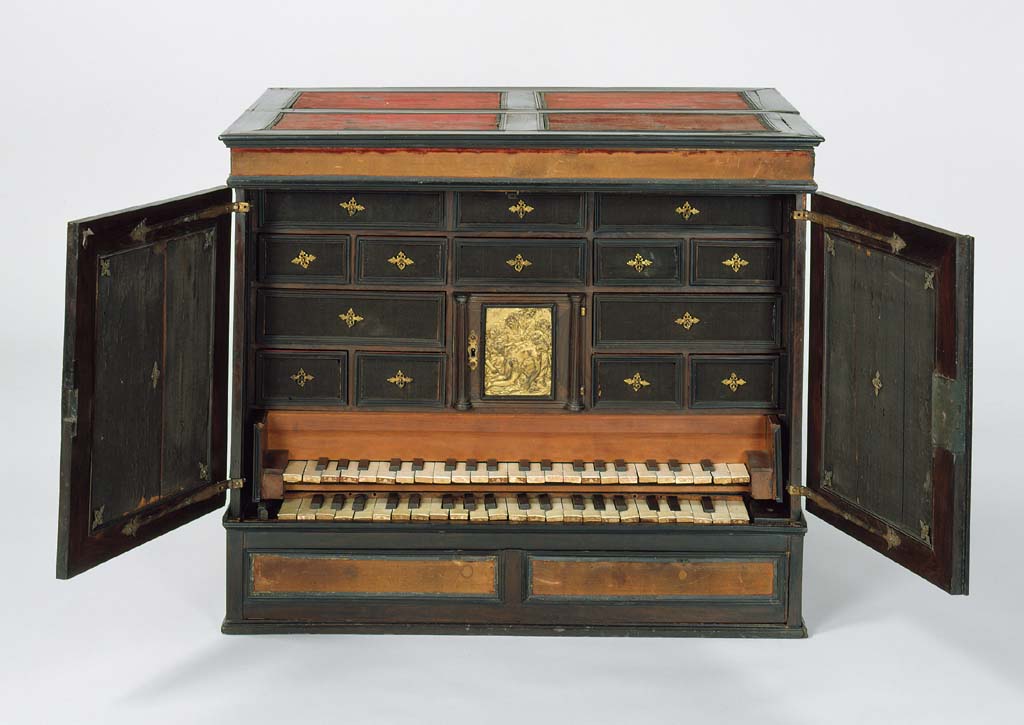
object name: claviorganum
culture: german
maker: lorenz hauslaib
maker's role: maker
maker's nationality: german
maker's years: 1568-1625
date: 1598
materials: bone, wood, lead, leather, metal, parchment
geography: germany